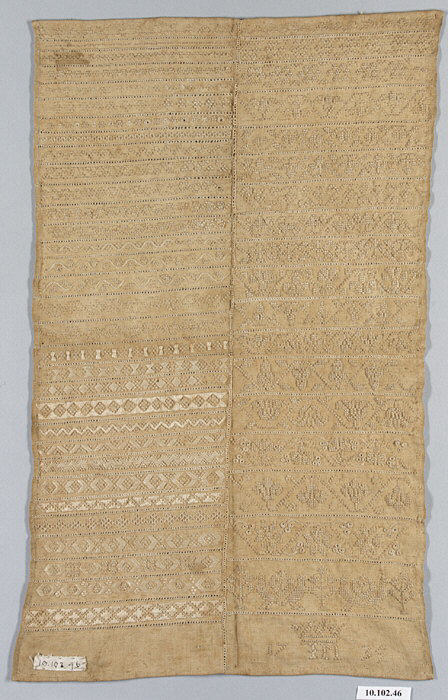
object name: sampler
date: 1735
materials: linen